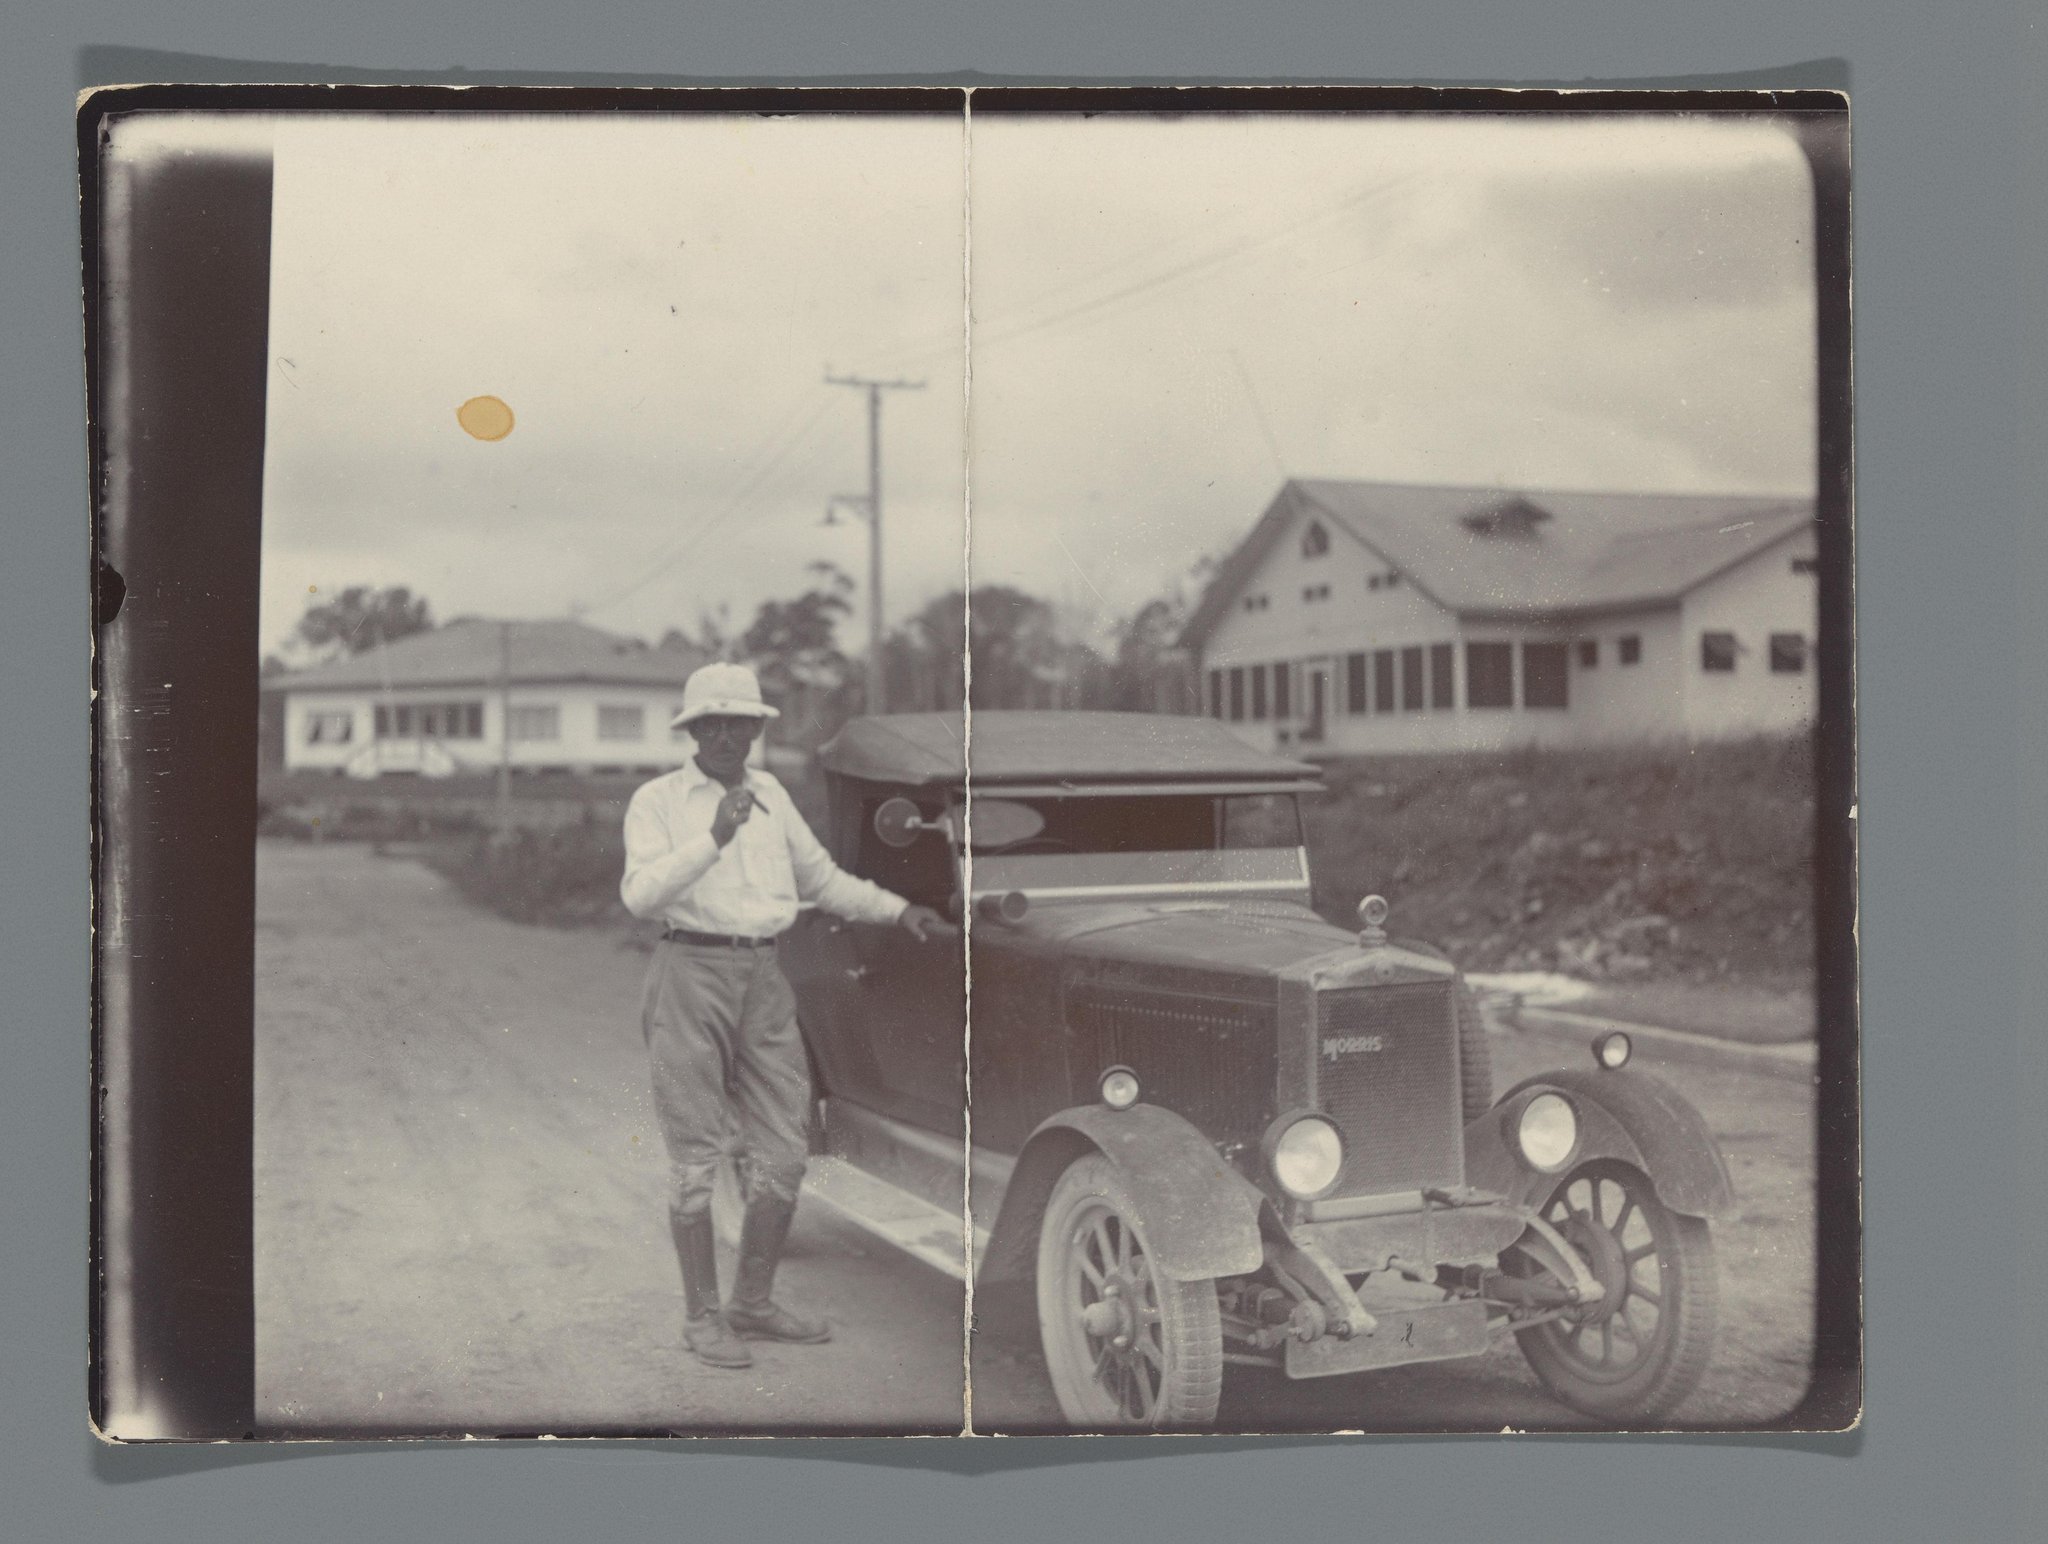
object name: photograph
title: Ingenieur Jetten bij zijn auto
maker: Anonymous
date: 1925-1927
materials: photographic support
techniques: photography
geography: suriname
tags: jetten, familie, moengo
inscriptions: inscription: ‘Jetten op het punt in zijn autotje te stappen om naar het werk te gaan: ik was toen een beetje ziek daarom ben ik zoo in elkaar gedrukt.’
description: Ingenieur Jetten staande bij zijn auto om naar zijn werk te gaan. Onderdeel van het ensemble met foto's van de familie van ingenieur Jetten in de mijnbouwstad Moengo in Suriname.